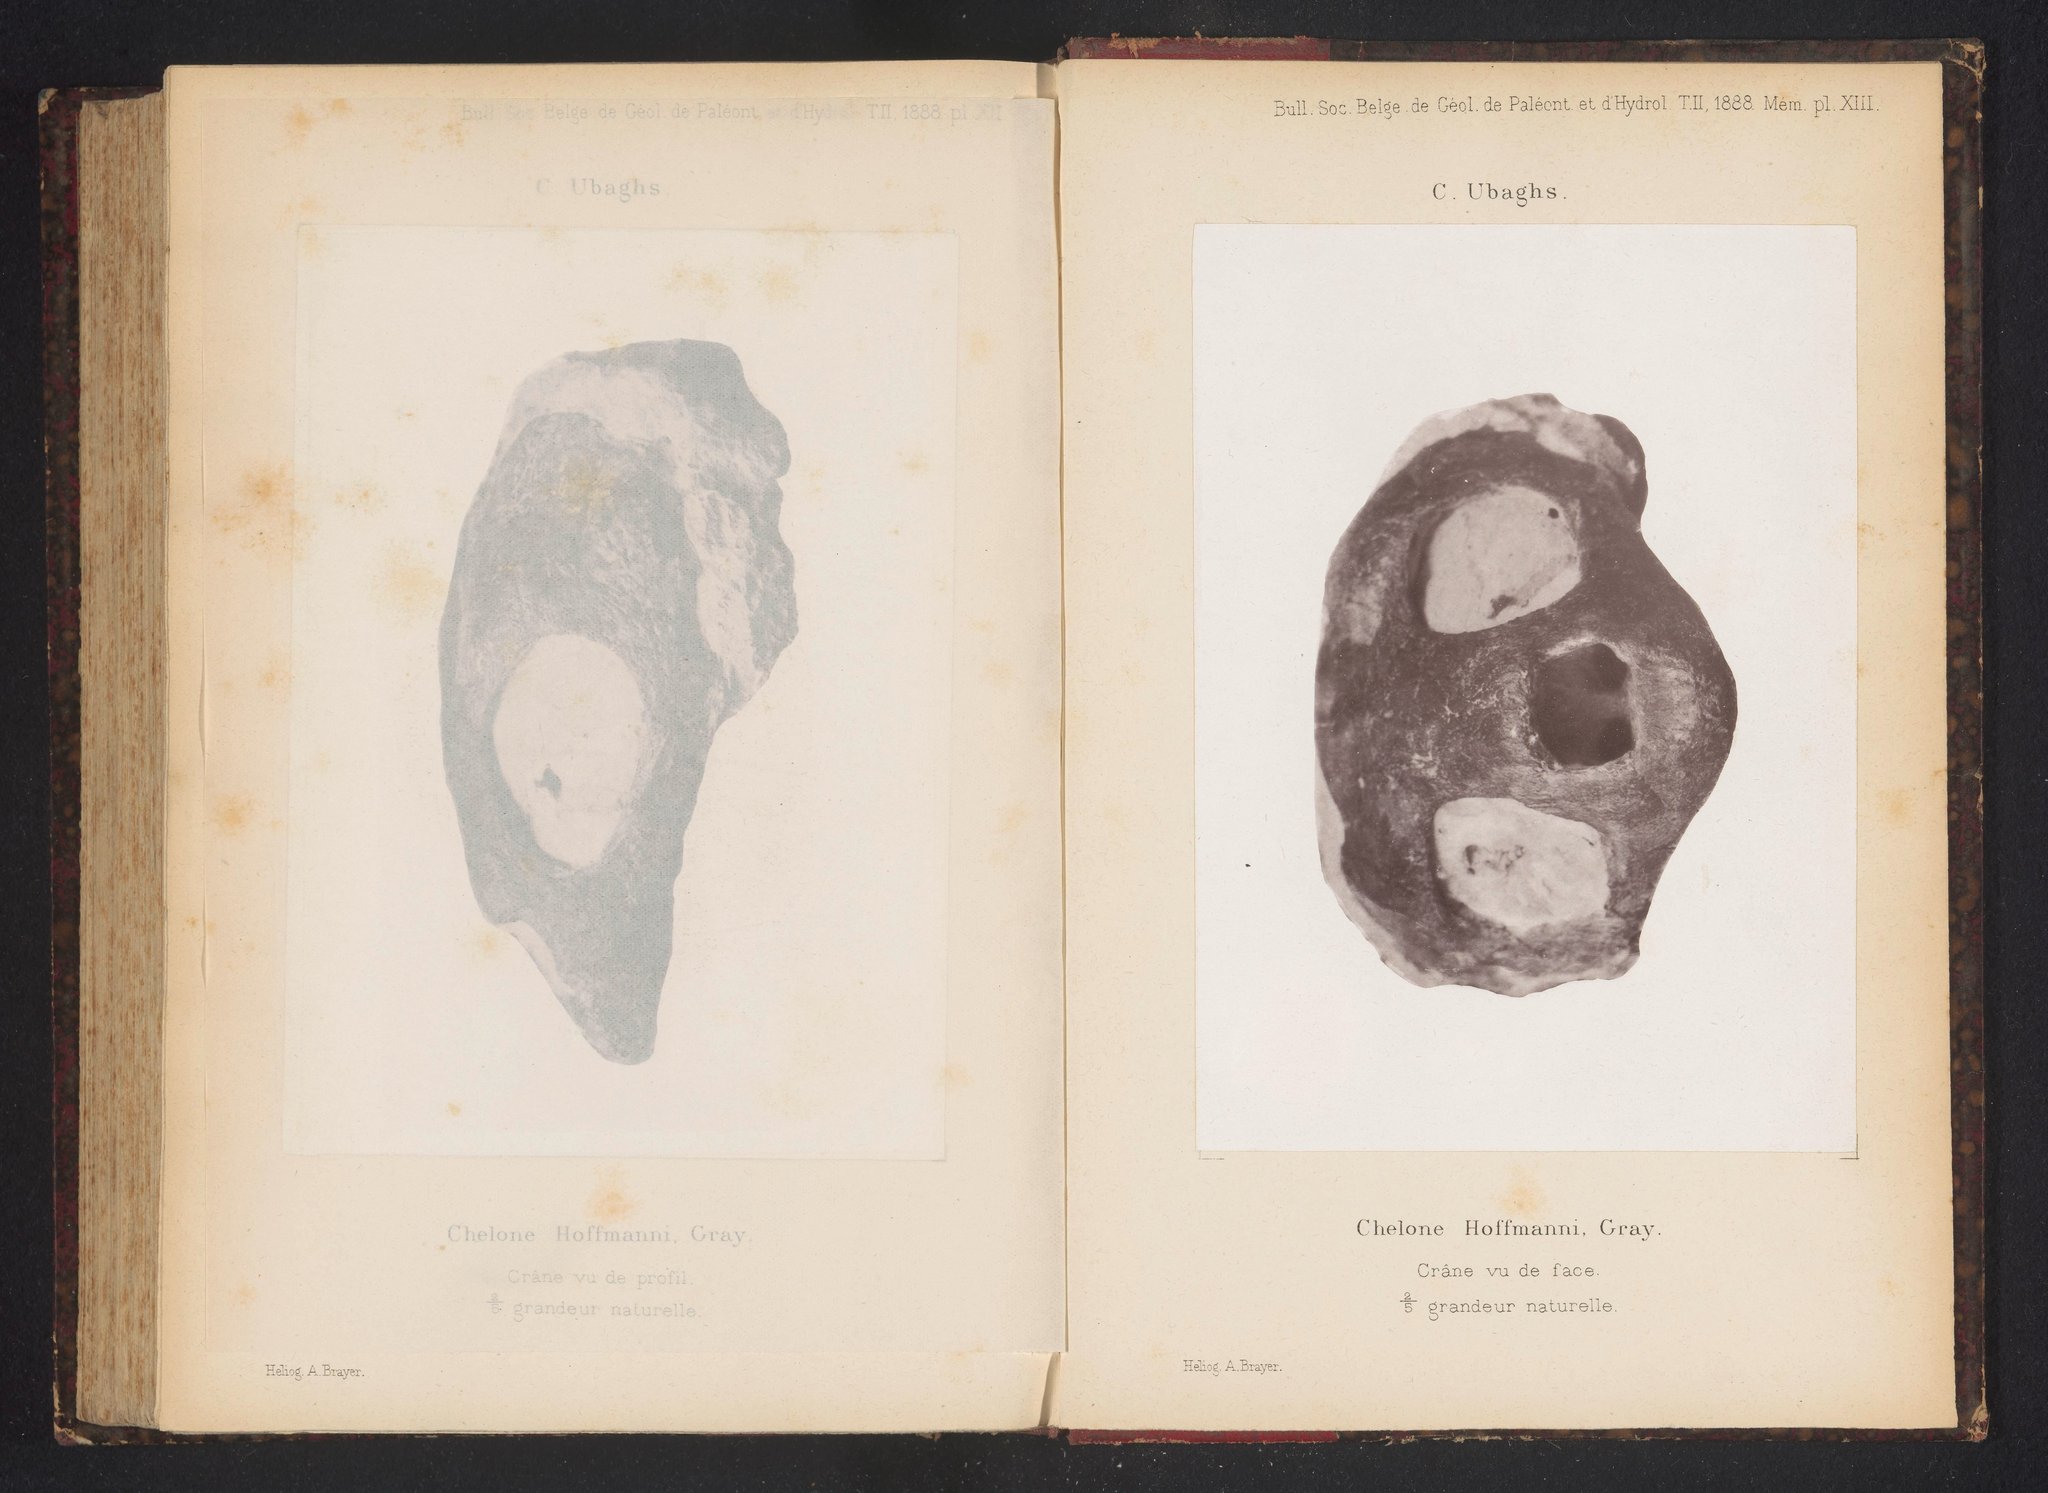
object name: page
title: Fossiel van een schildpadkop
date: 1883-1888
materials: paper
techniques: photograph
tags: fossil animals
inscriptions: dedication: ‘Crâne vu de face/ 2/5 grandeur naturelle’, inscription: ‘Bull. Soc. Belge. de Géol. de Paléont. et d'Hydrol. T.II, 1888 pl.XIII./ C. Ubaghs’